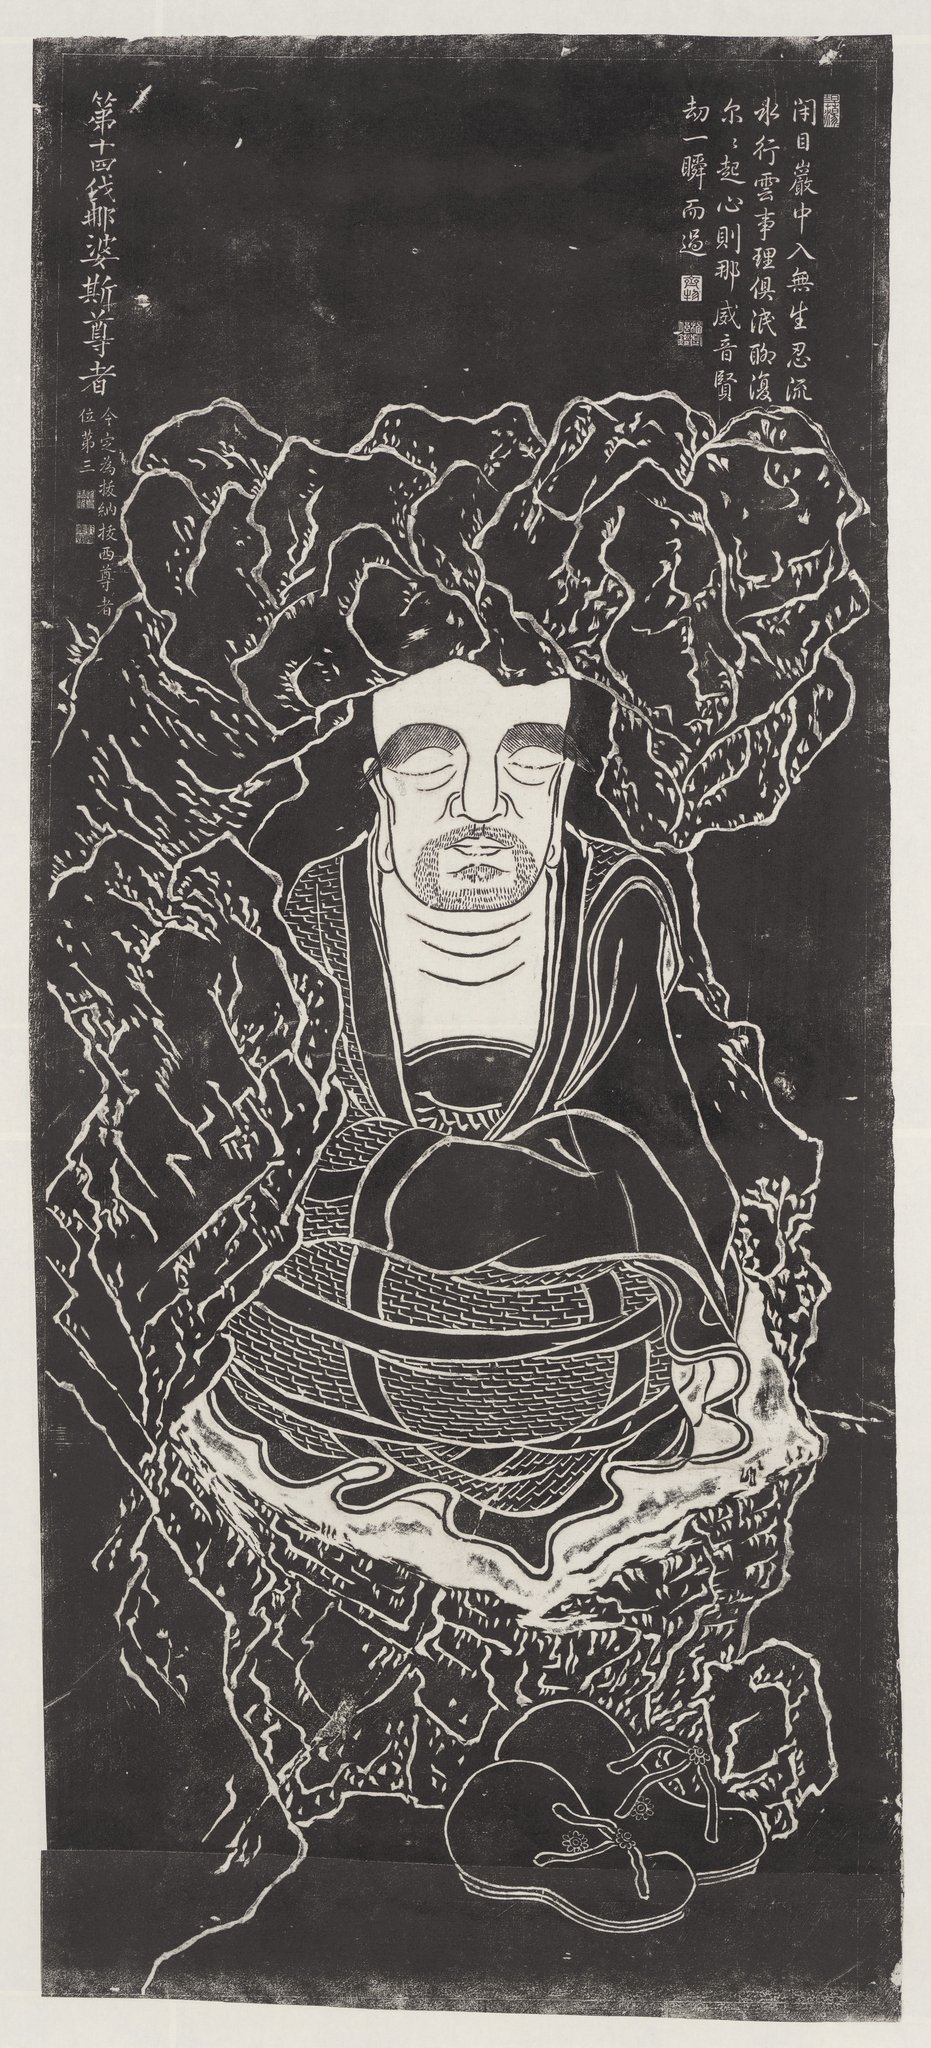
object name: rubbing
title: Luohan, after a set attributed to Guanxiu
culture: chinese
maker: unidentified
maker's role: artist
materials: ink, paper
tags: men